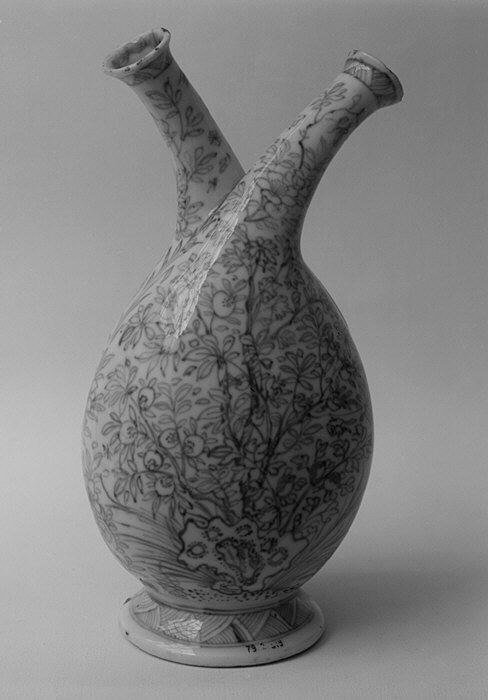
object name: cruet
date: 1710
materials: hard paste porcelain